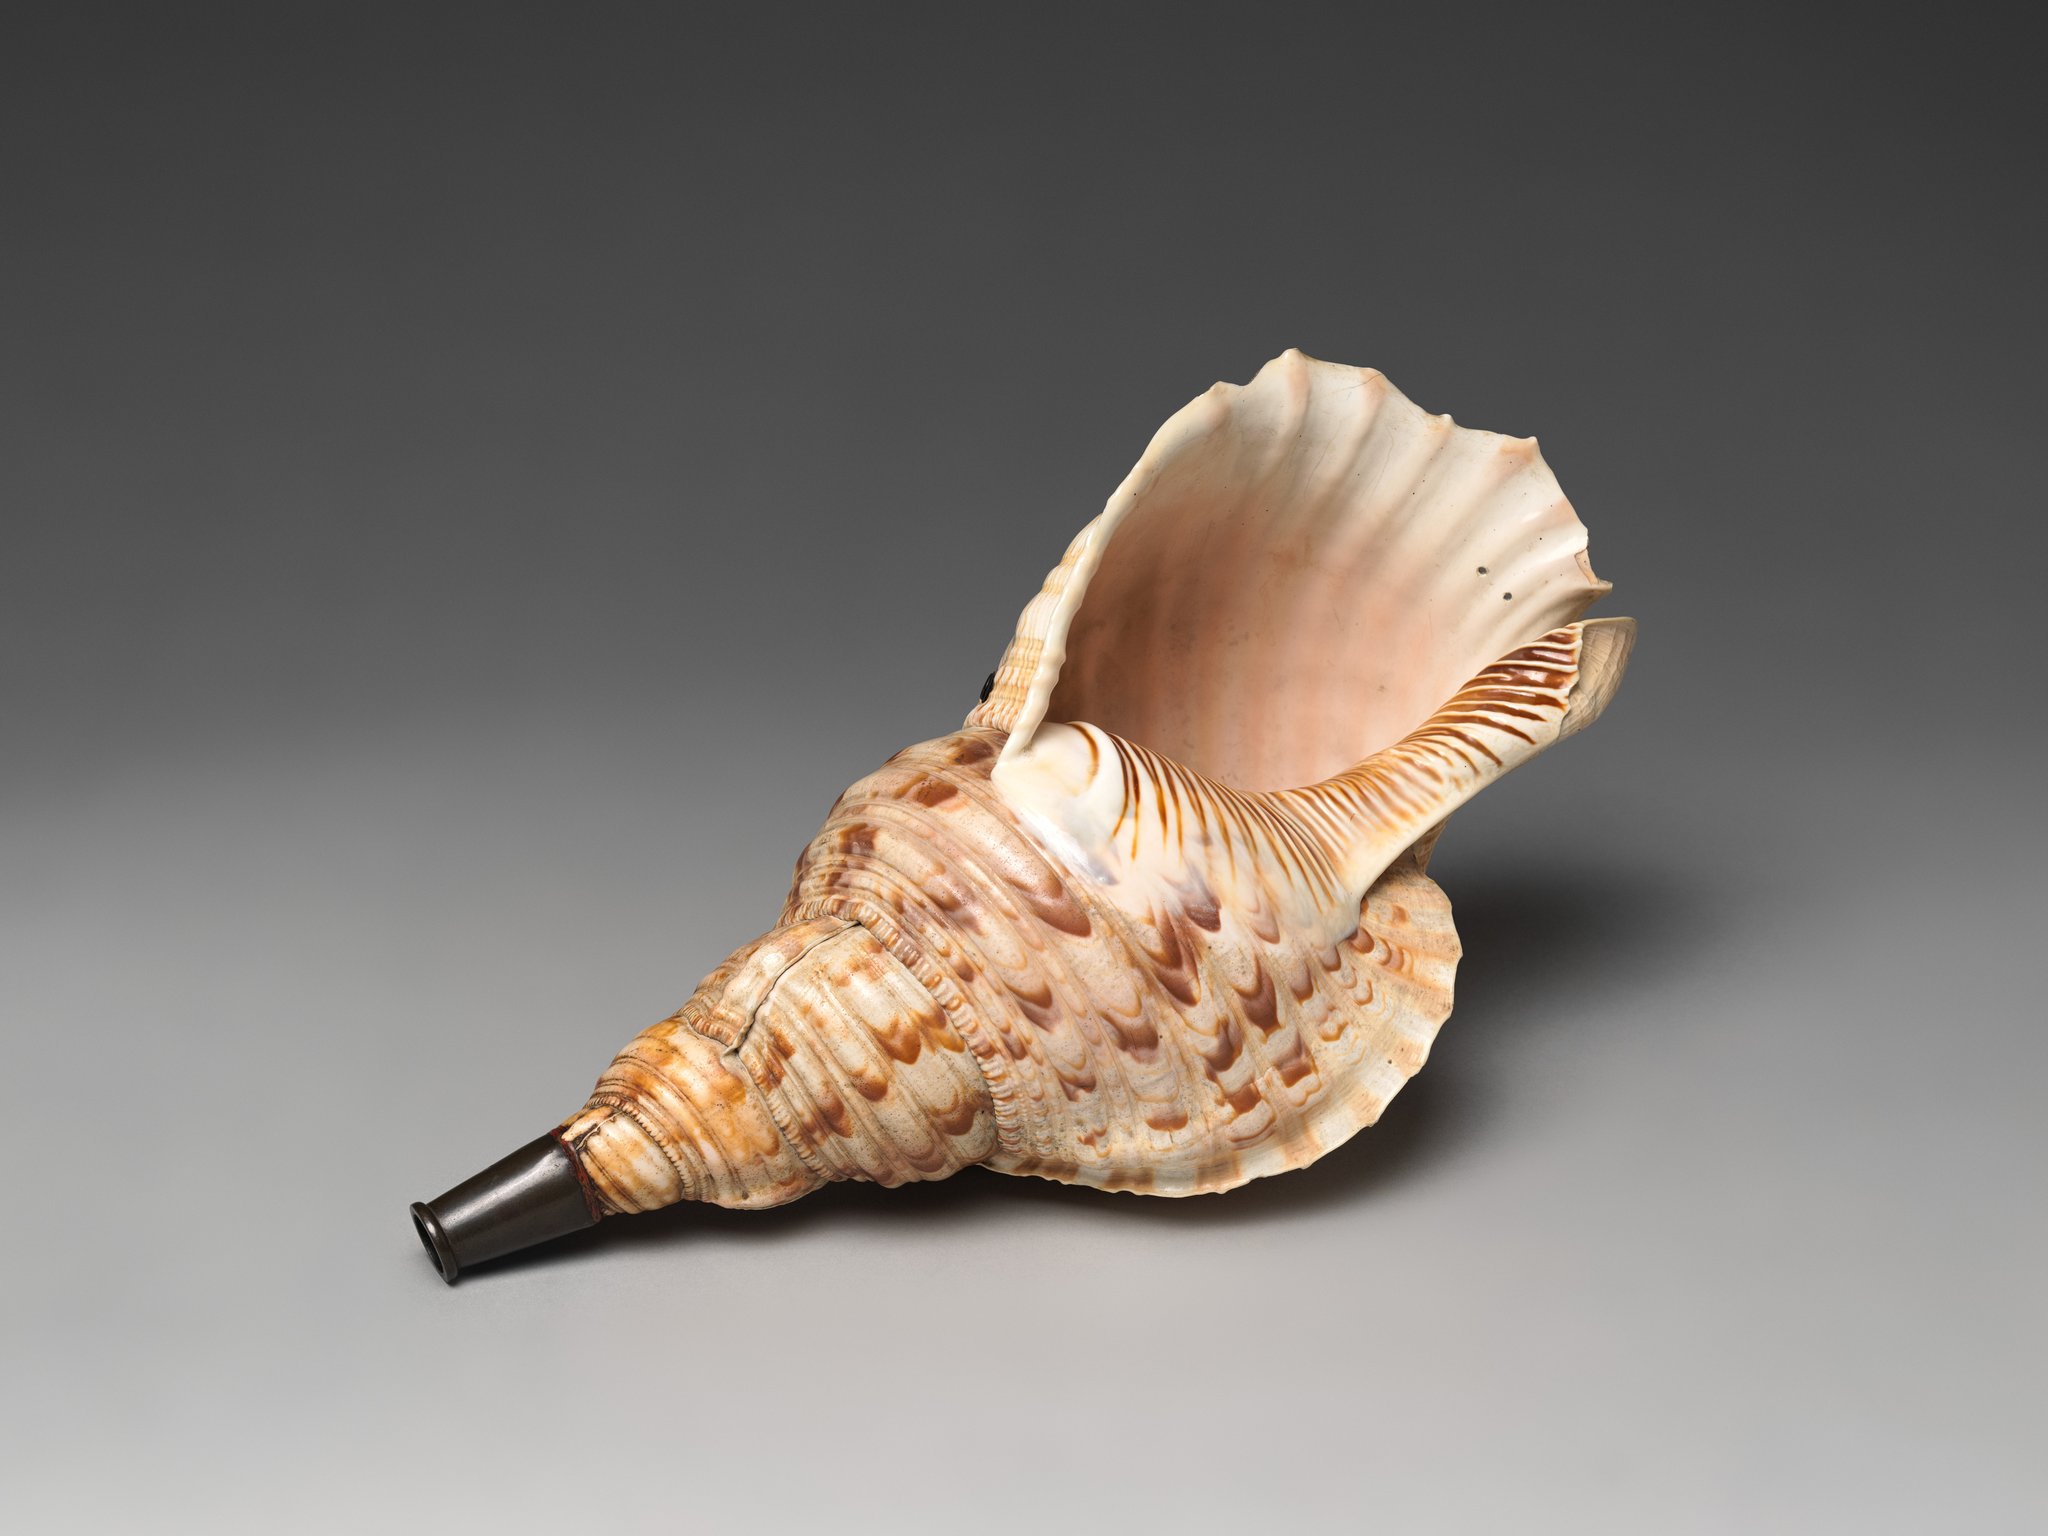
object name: hora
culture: japanese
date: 1801-1900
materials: metal, shell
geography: japan